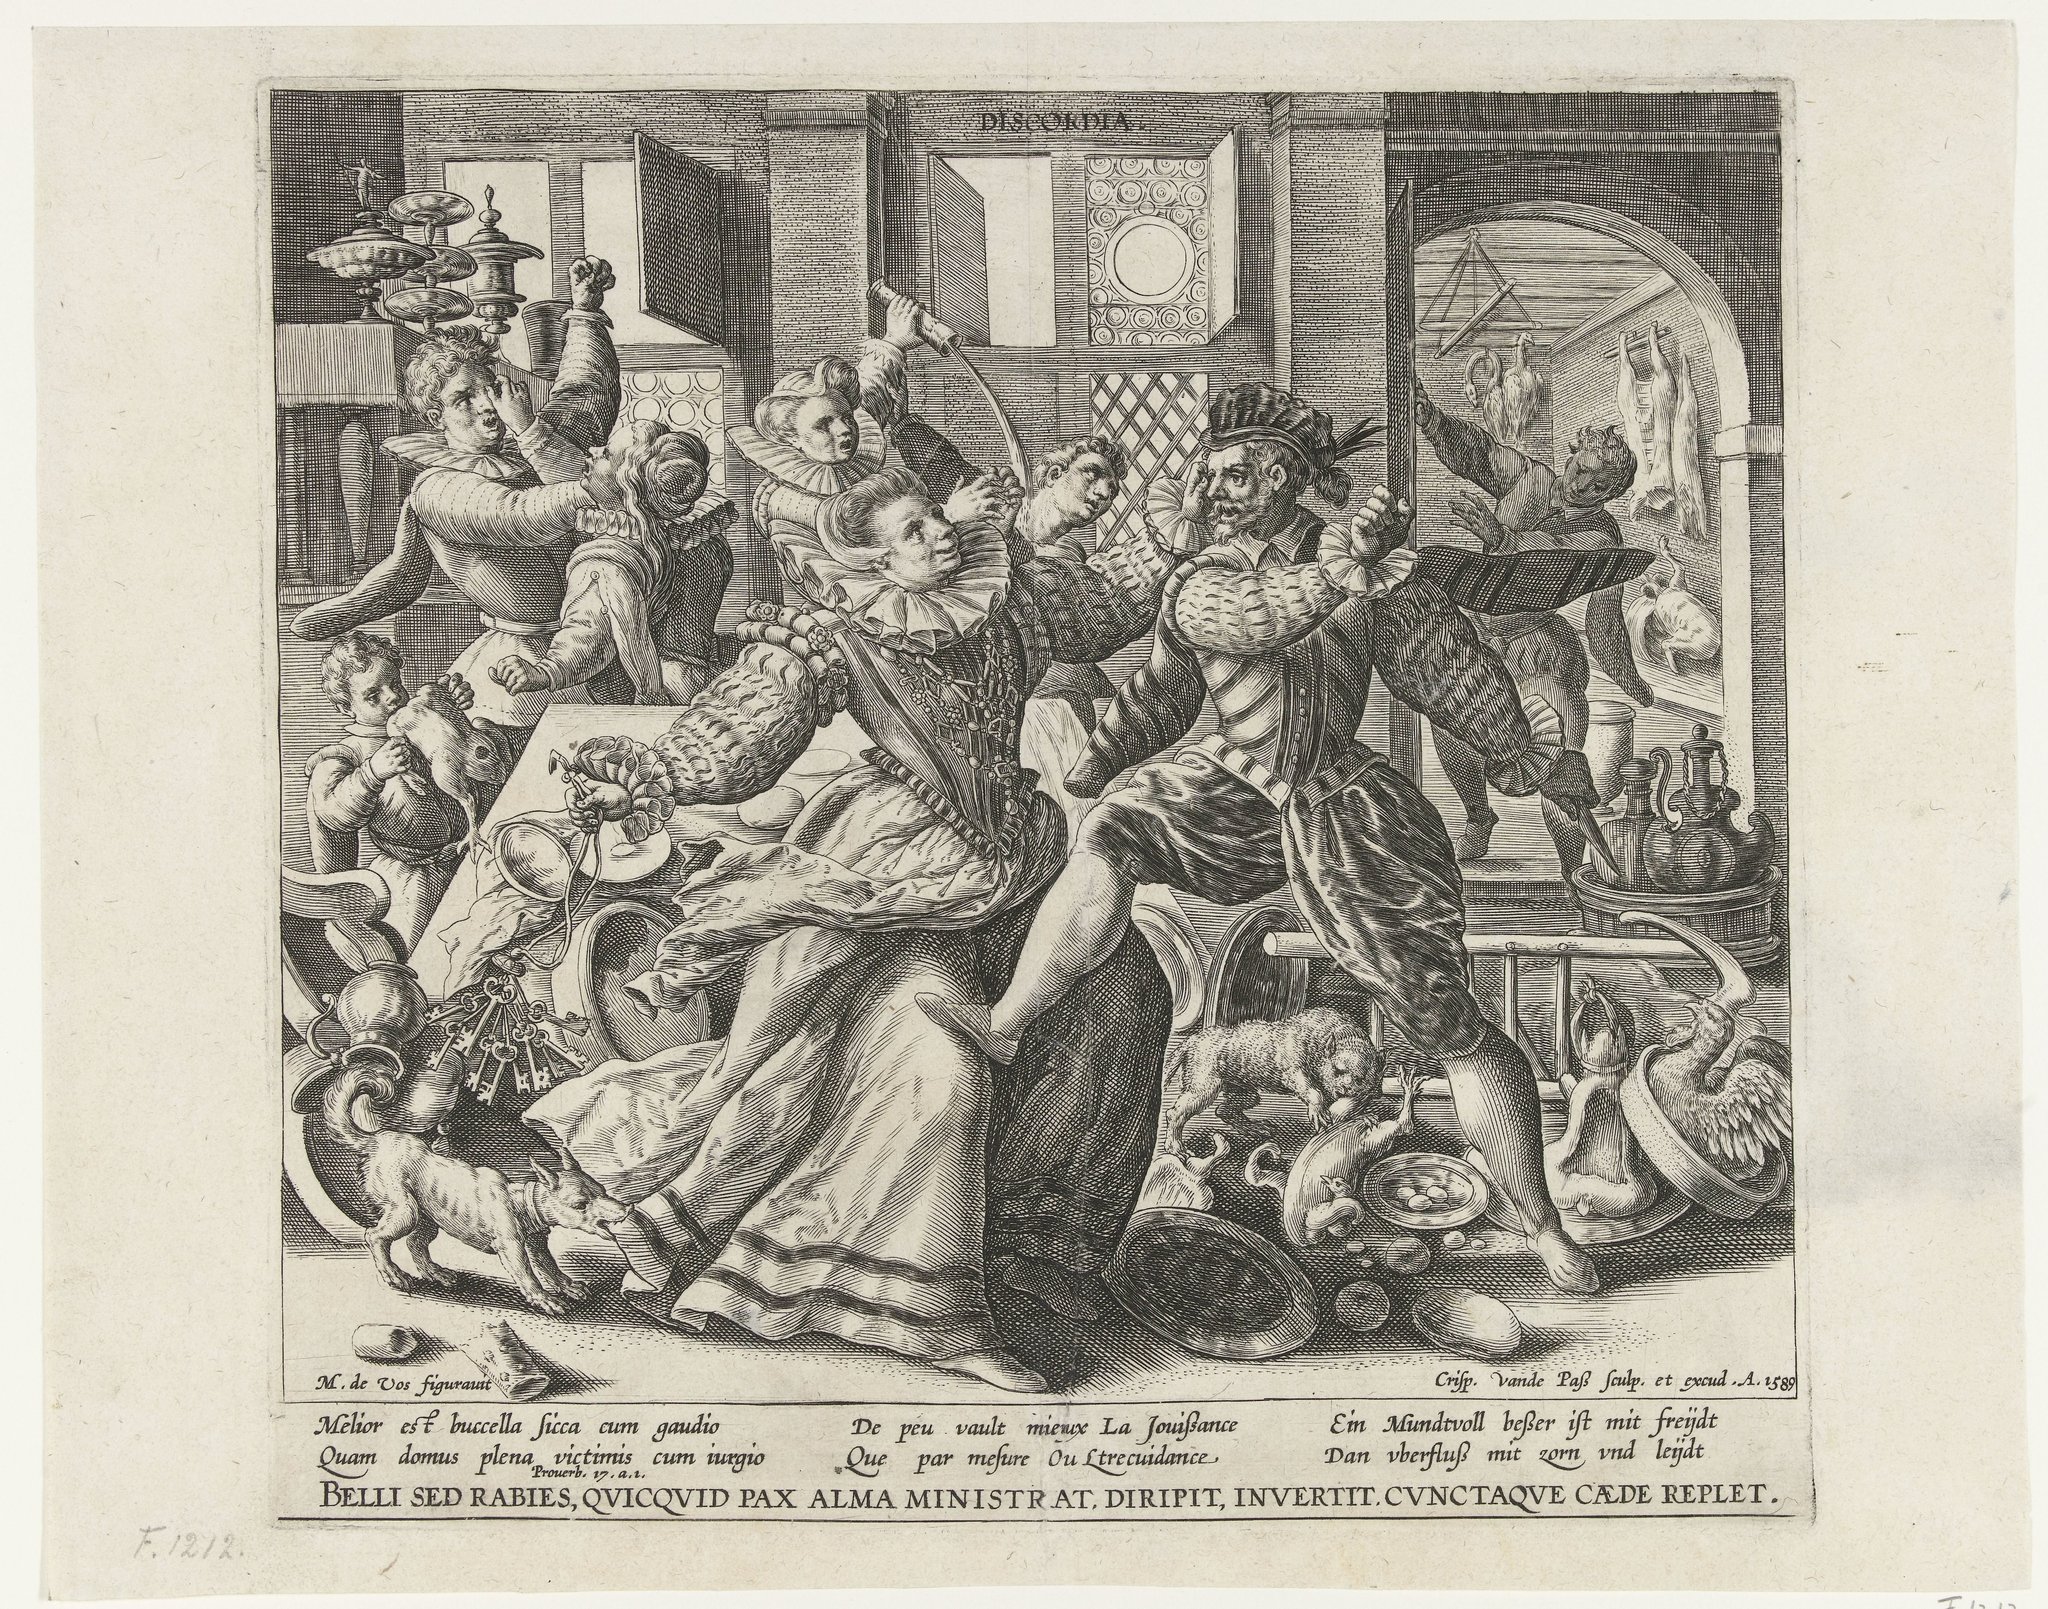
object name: print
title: Het slechte huishouden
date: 1589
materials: paper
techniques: engraving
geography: cologne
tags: disagreement, discord; 'discordia' (ripa), fighting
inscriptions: collector's mark: Lugt 2760, collector's mark: Lugt 2228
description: De verbeelding van de ondeugd Tweedracht (Discordia): interieur met drie elegant geklede paren die met elkaar aan het vechten zijn. Allerlei huisraad is op de grond gevallen. Een hond bijt in de jurk van een vrouw. Een kind en een kat nemen een hap van een kalkoen. In de marge een zesregelig Bijbelcitaat uit Spr. 17 en een motto in het Latijn. Pendant van een prent met het goede huishouden.